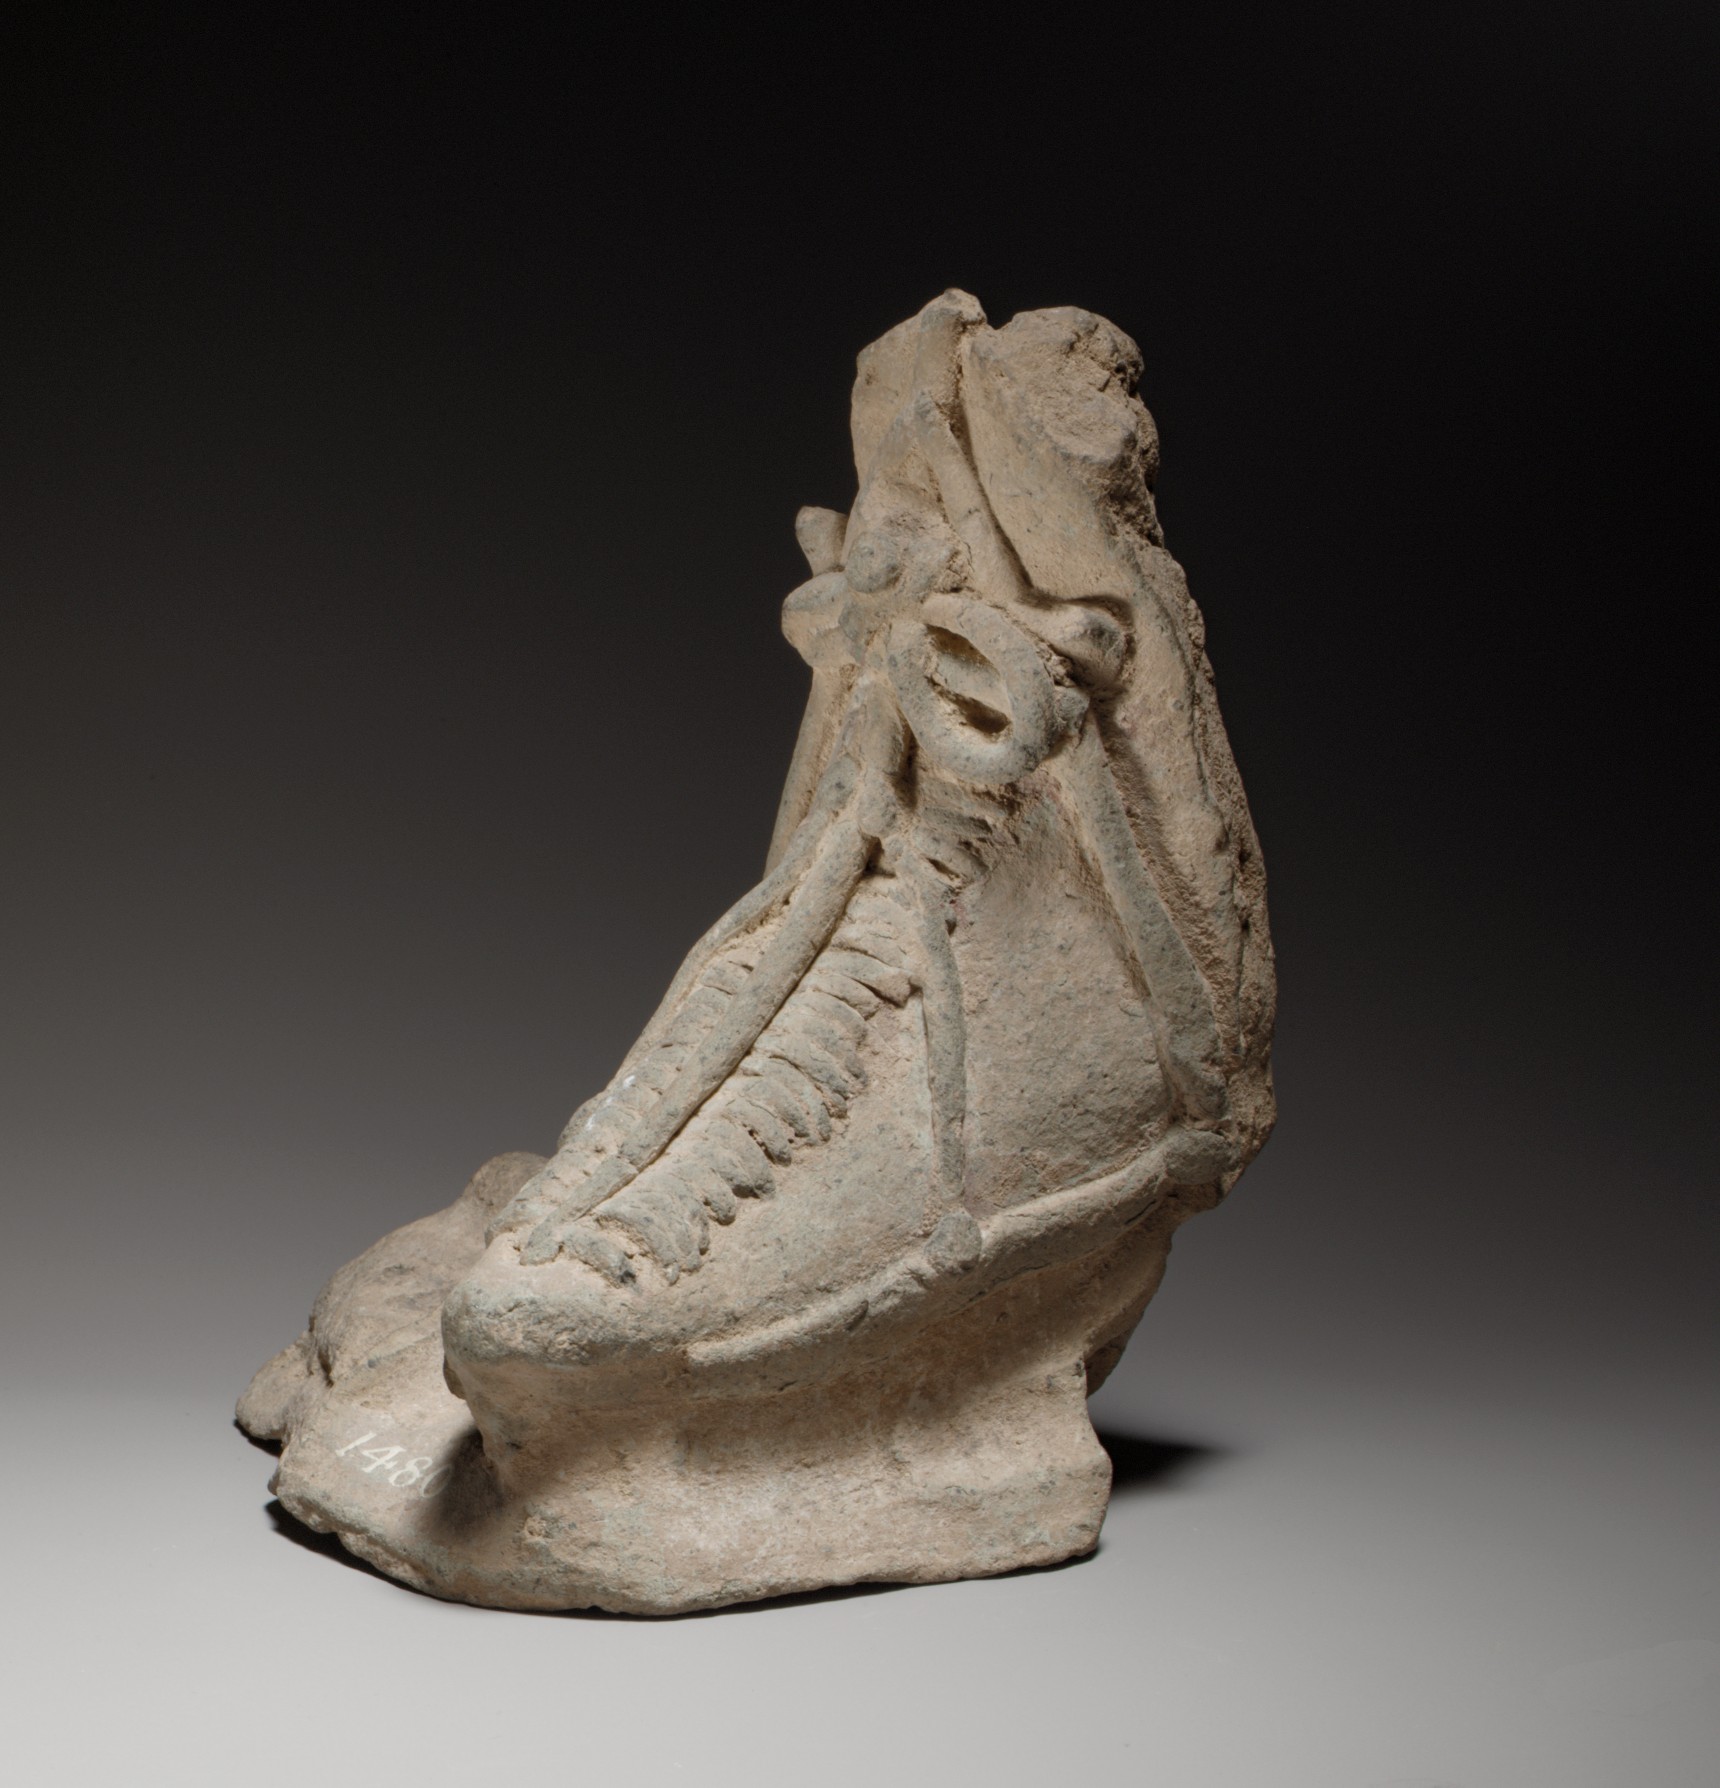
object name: foot with shoe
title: Left foot, possibly from a relief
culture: cypriot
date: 200-101 BCE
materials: terracotta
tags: shoes